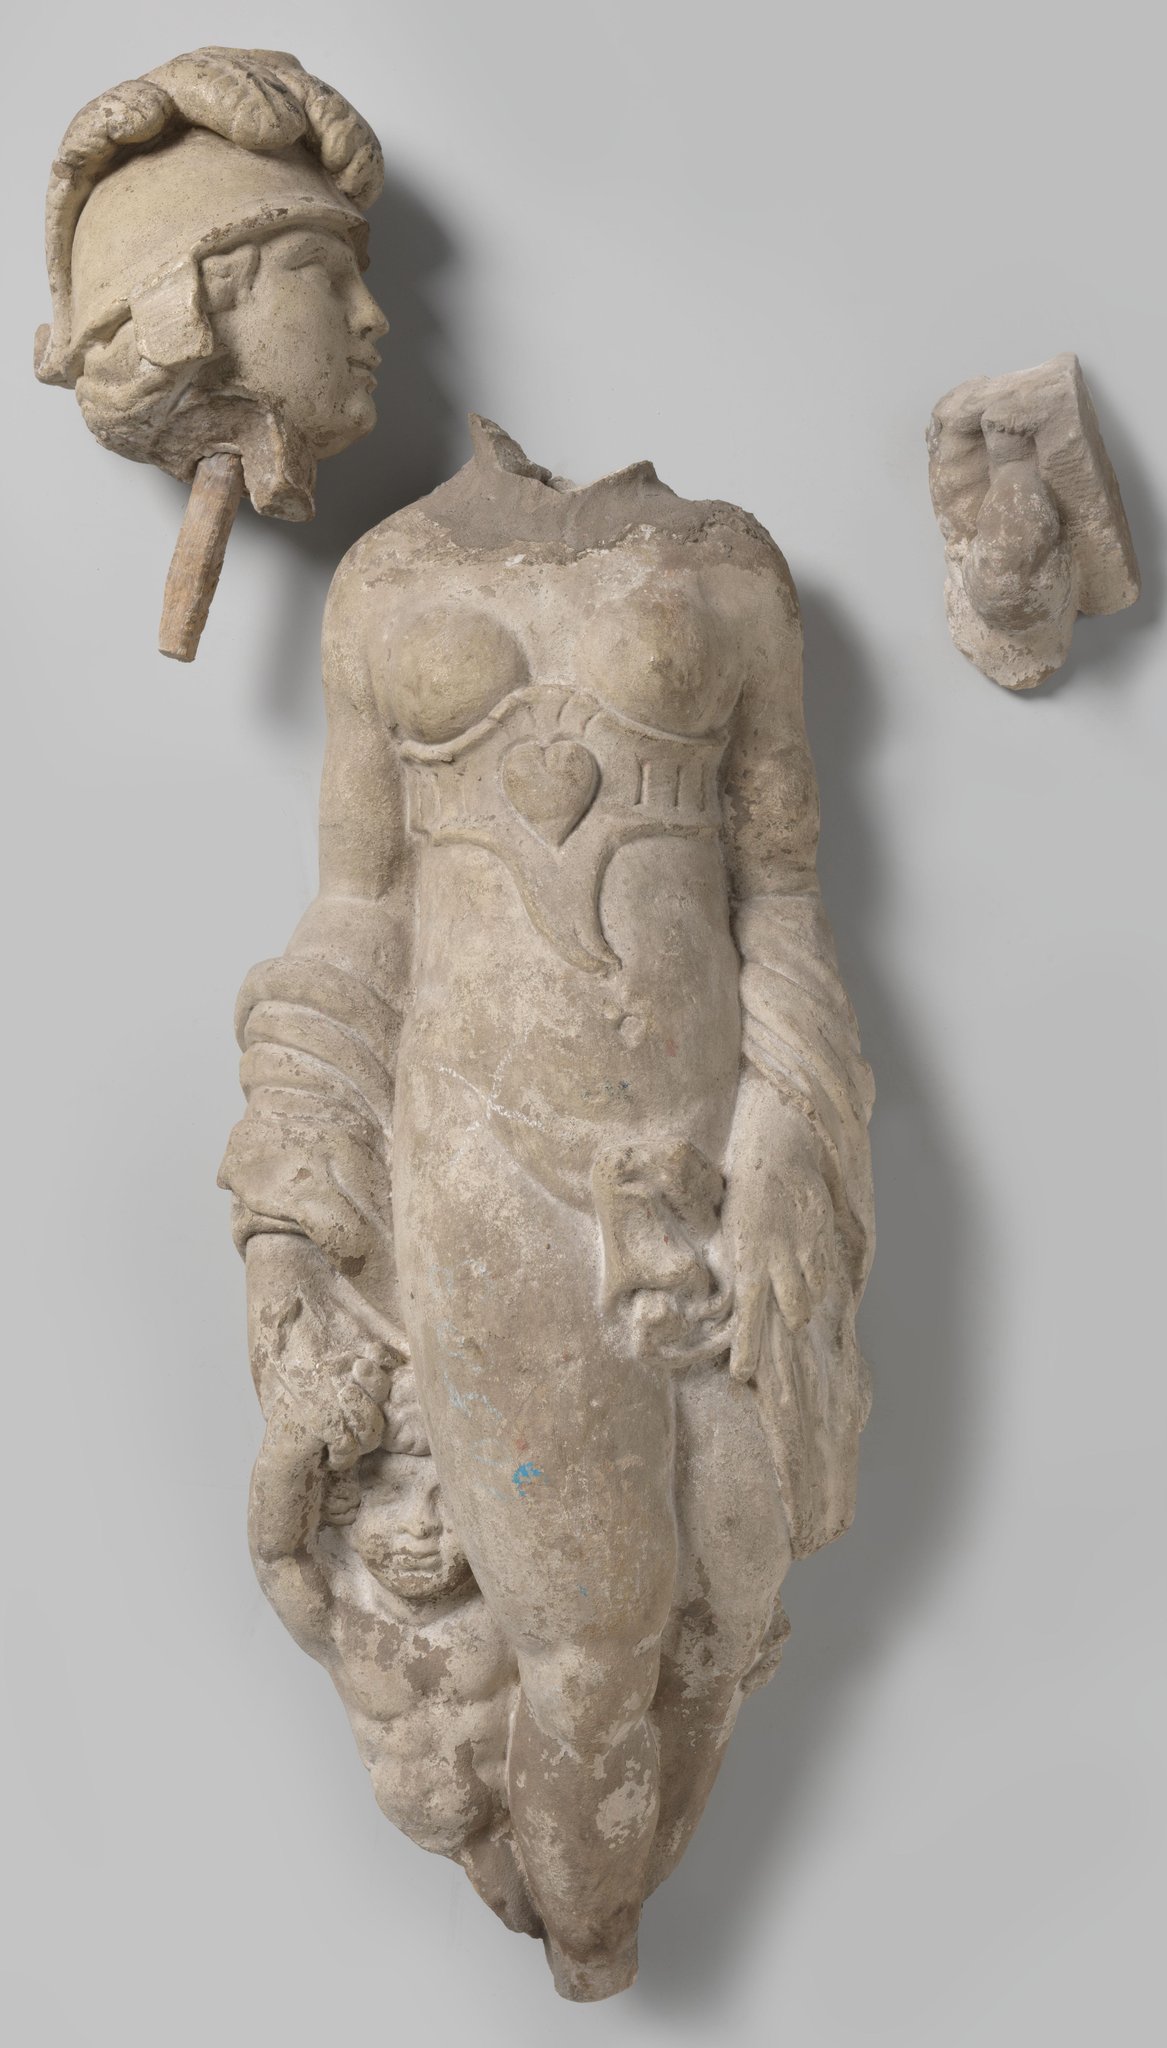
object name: sculpture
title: Vrouwenfiguur, naakt, met afgebroken gehelmd hoofd.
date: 1400-1950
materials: stone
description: Naakte vrouw ten voeten uit staand met om haar middel een band waarop een hart. Aan haar rechterhand een kind. Het gehelmde hoofd is afgebroken.